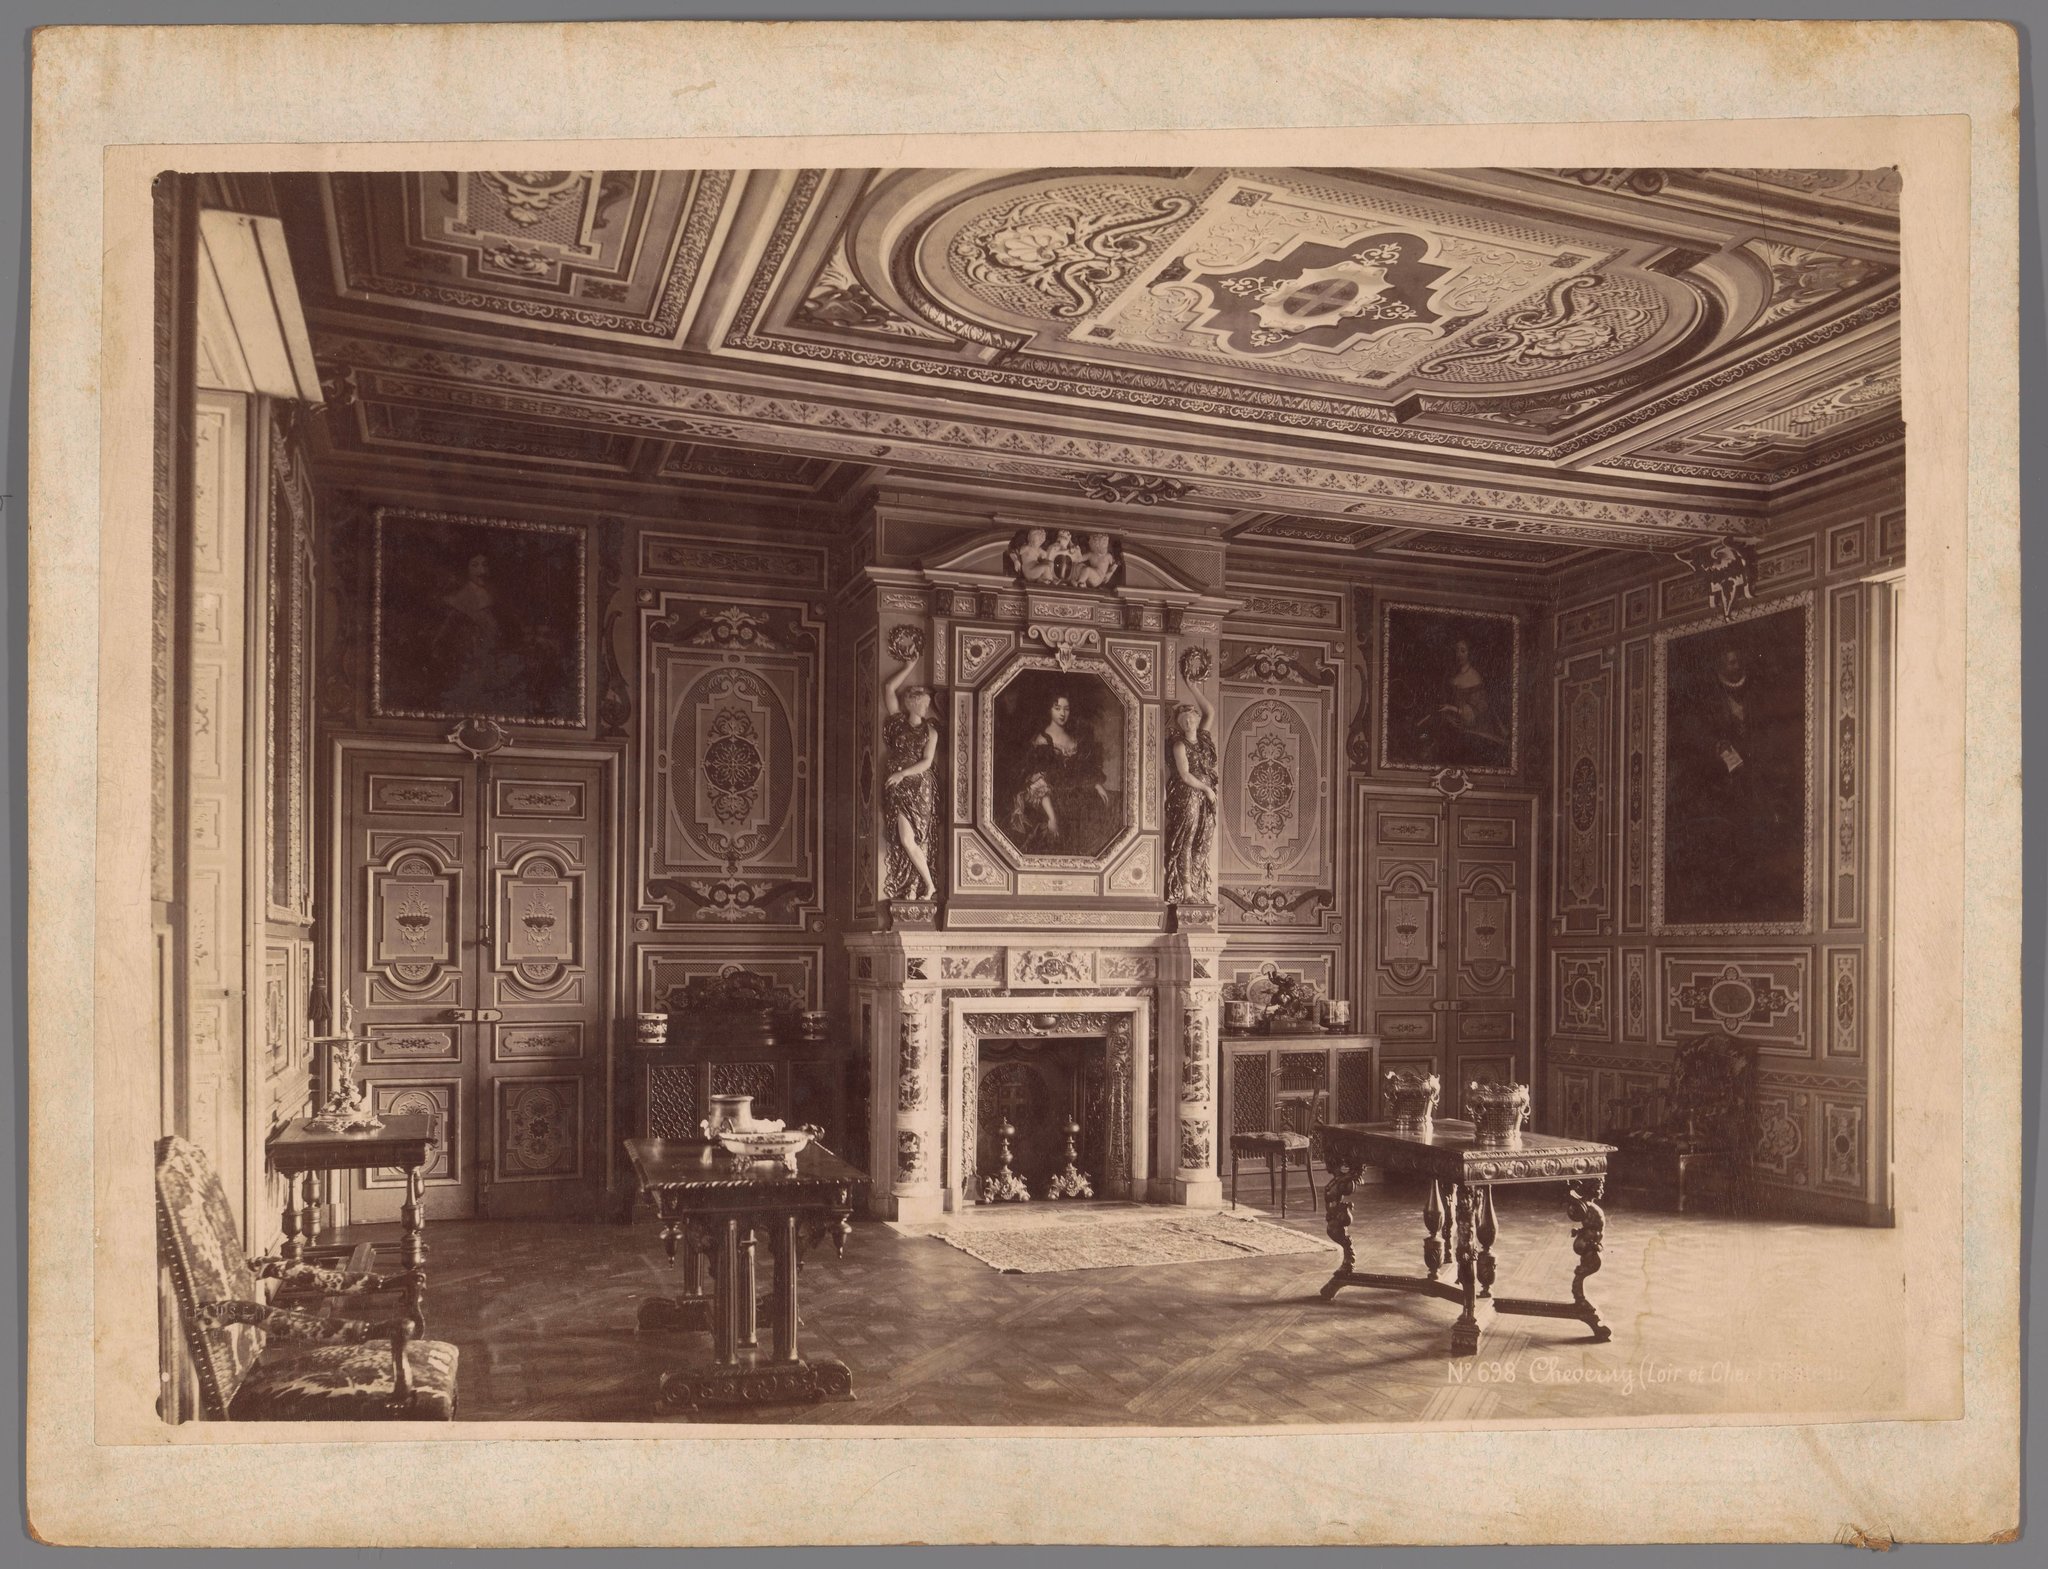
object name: photograph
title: Interieur van de Grand Salon in het Kasteel van Cheverny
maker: séraphin-médéric mieusement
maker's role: fotograaf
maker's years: 1840-1905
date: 1875-1900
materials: cardboard, photographic support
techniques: albumen print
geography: château de cheverny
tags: drawing-room, 'salon', castle, open hearth, fire-place, interior ~ representation of a building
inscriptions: number: ‘No. 698’, name: ‘MIEUSEMENT PHOTOGRAPHE’, inscription: ‘MONUMENTS HISTORIQUES’, collector's mark: Lugt 3937